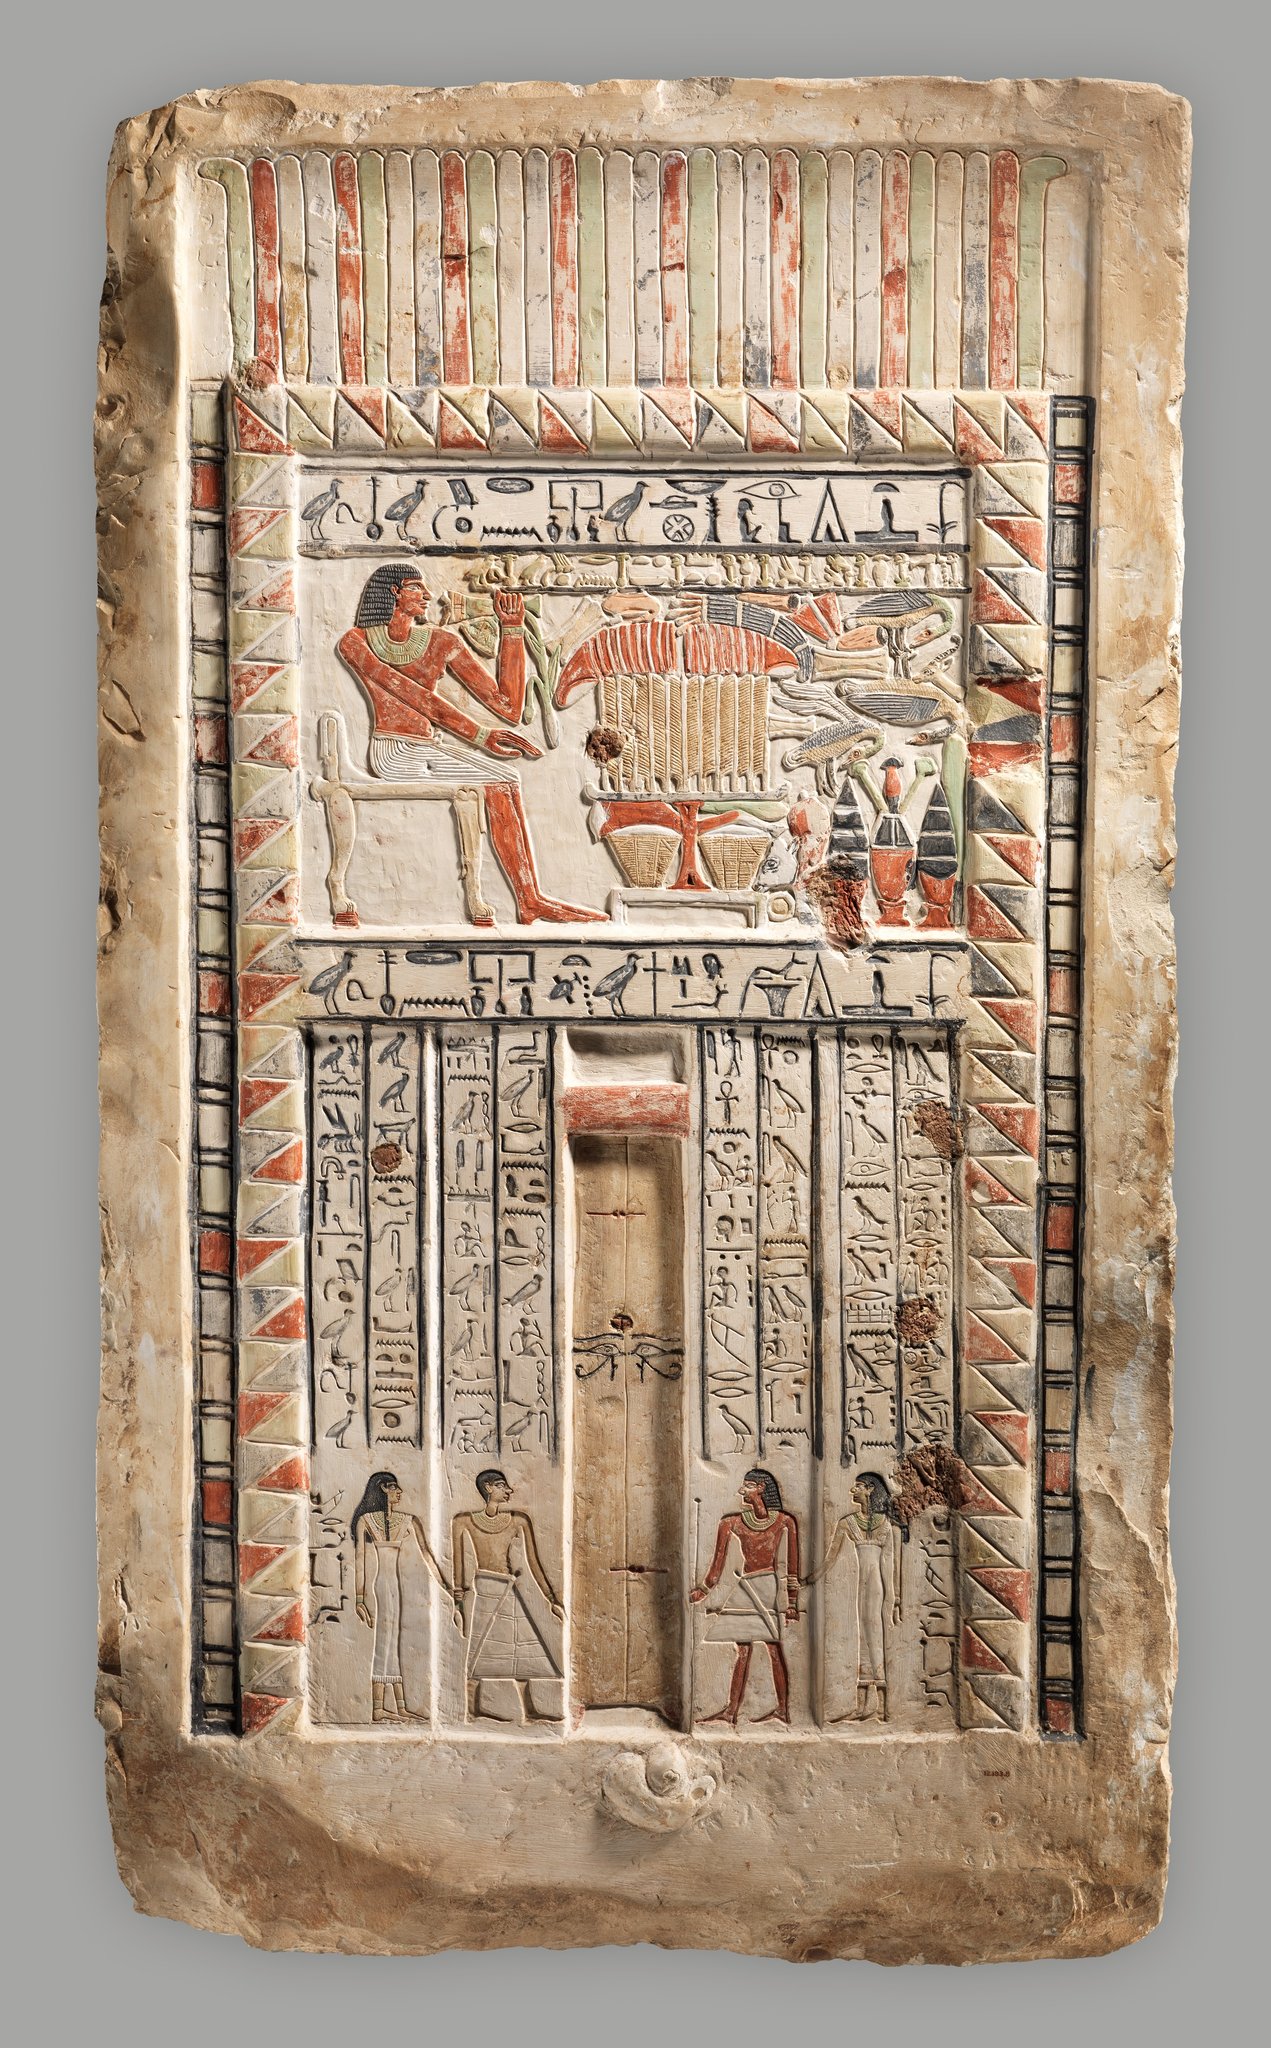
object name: false door, neferiu, wedjebet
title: False Door of the Royal Sealer Neferiu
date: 2150-2010 BCE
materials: limestone, paint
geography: northern upper egypt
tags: doors,men,women,hieroglyphs